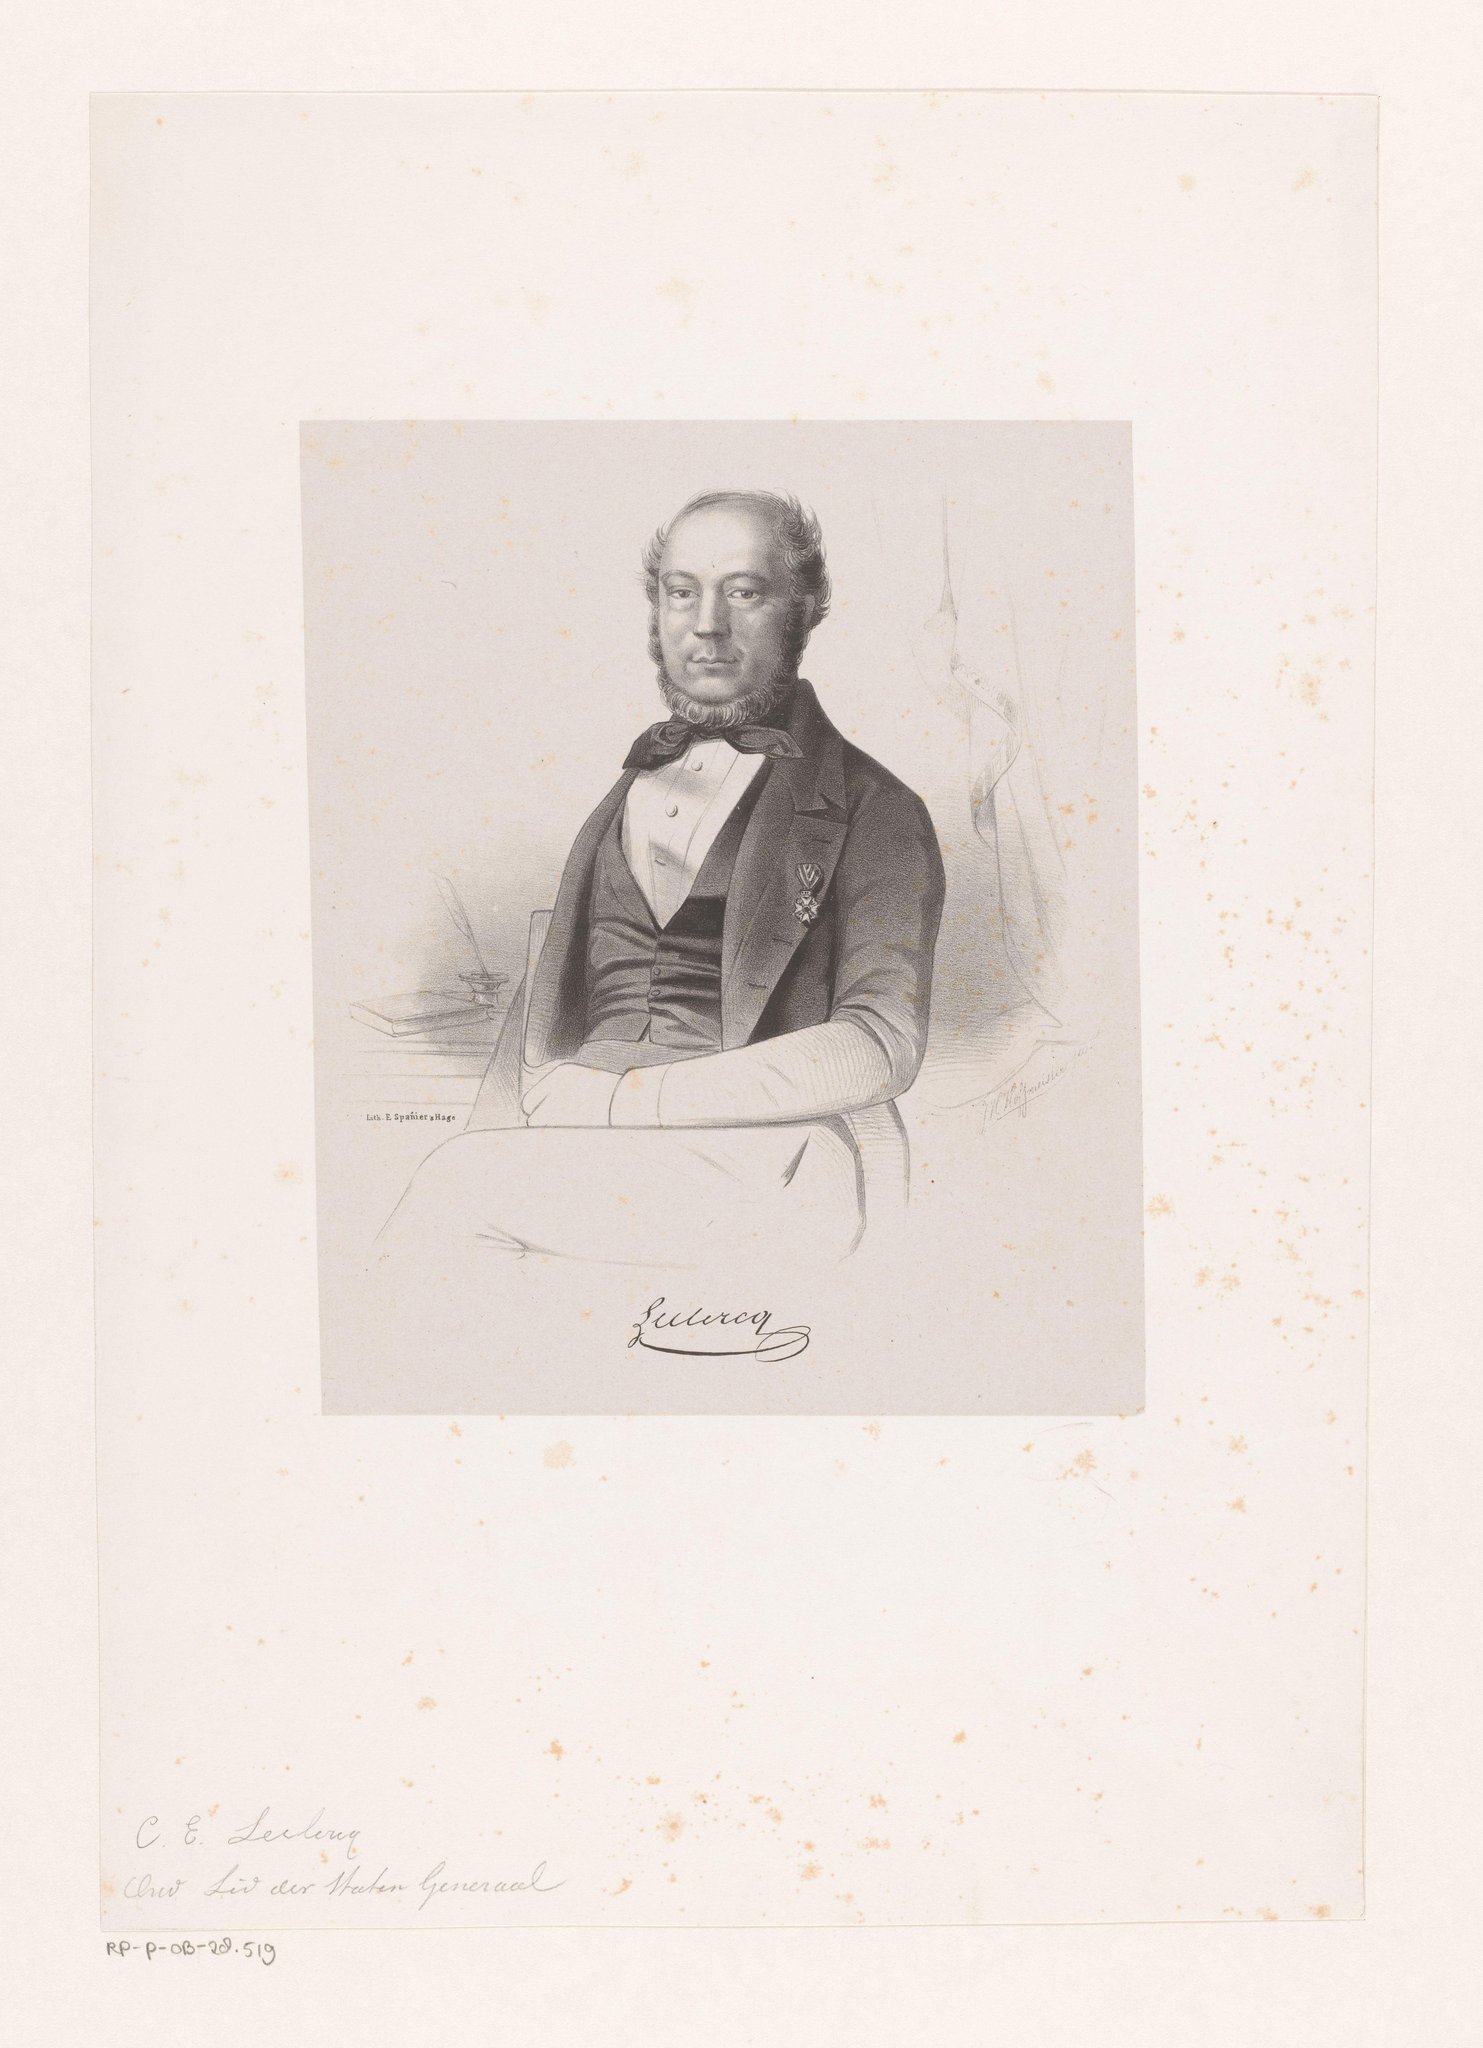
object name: print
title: Portret van ambtenaar C.E. Leclercq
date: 1843-1863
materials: paper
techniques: lithograph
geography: netherlands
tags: historical persons (+ three-quarter length portrait)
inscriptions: collector's mark: Lugt 2228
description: Onder het portret de signatuur van de geportretteerde.